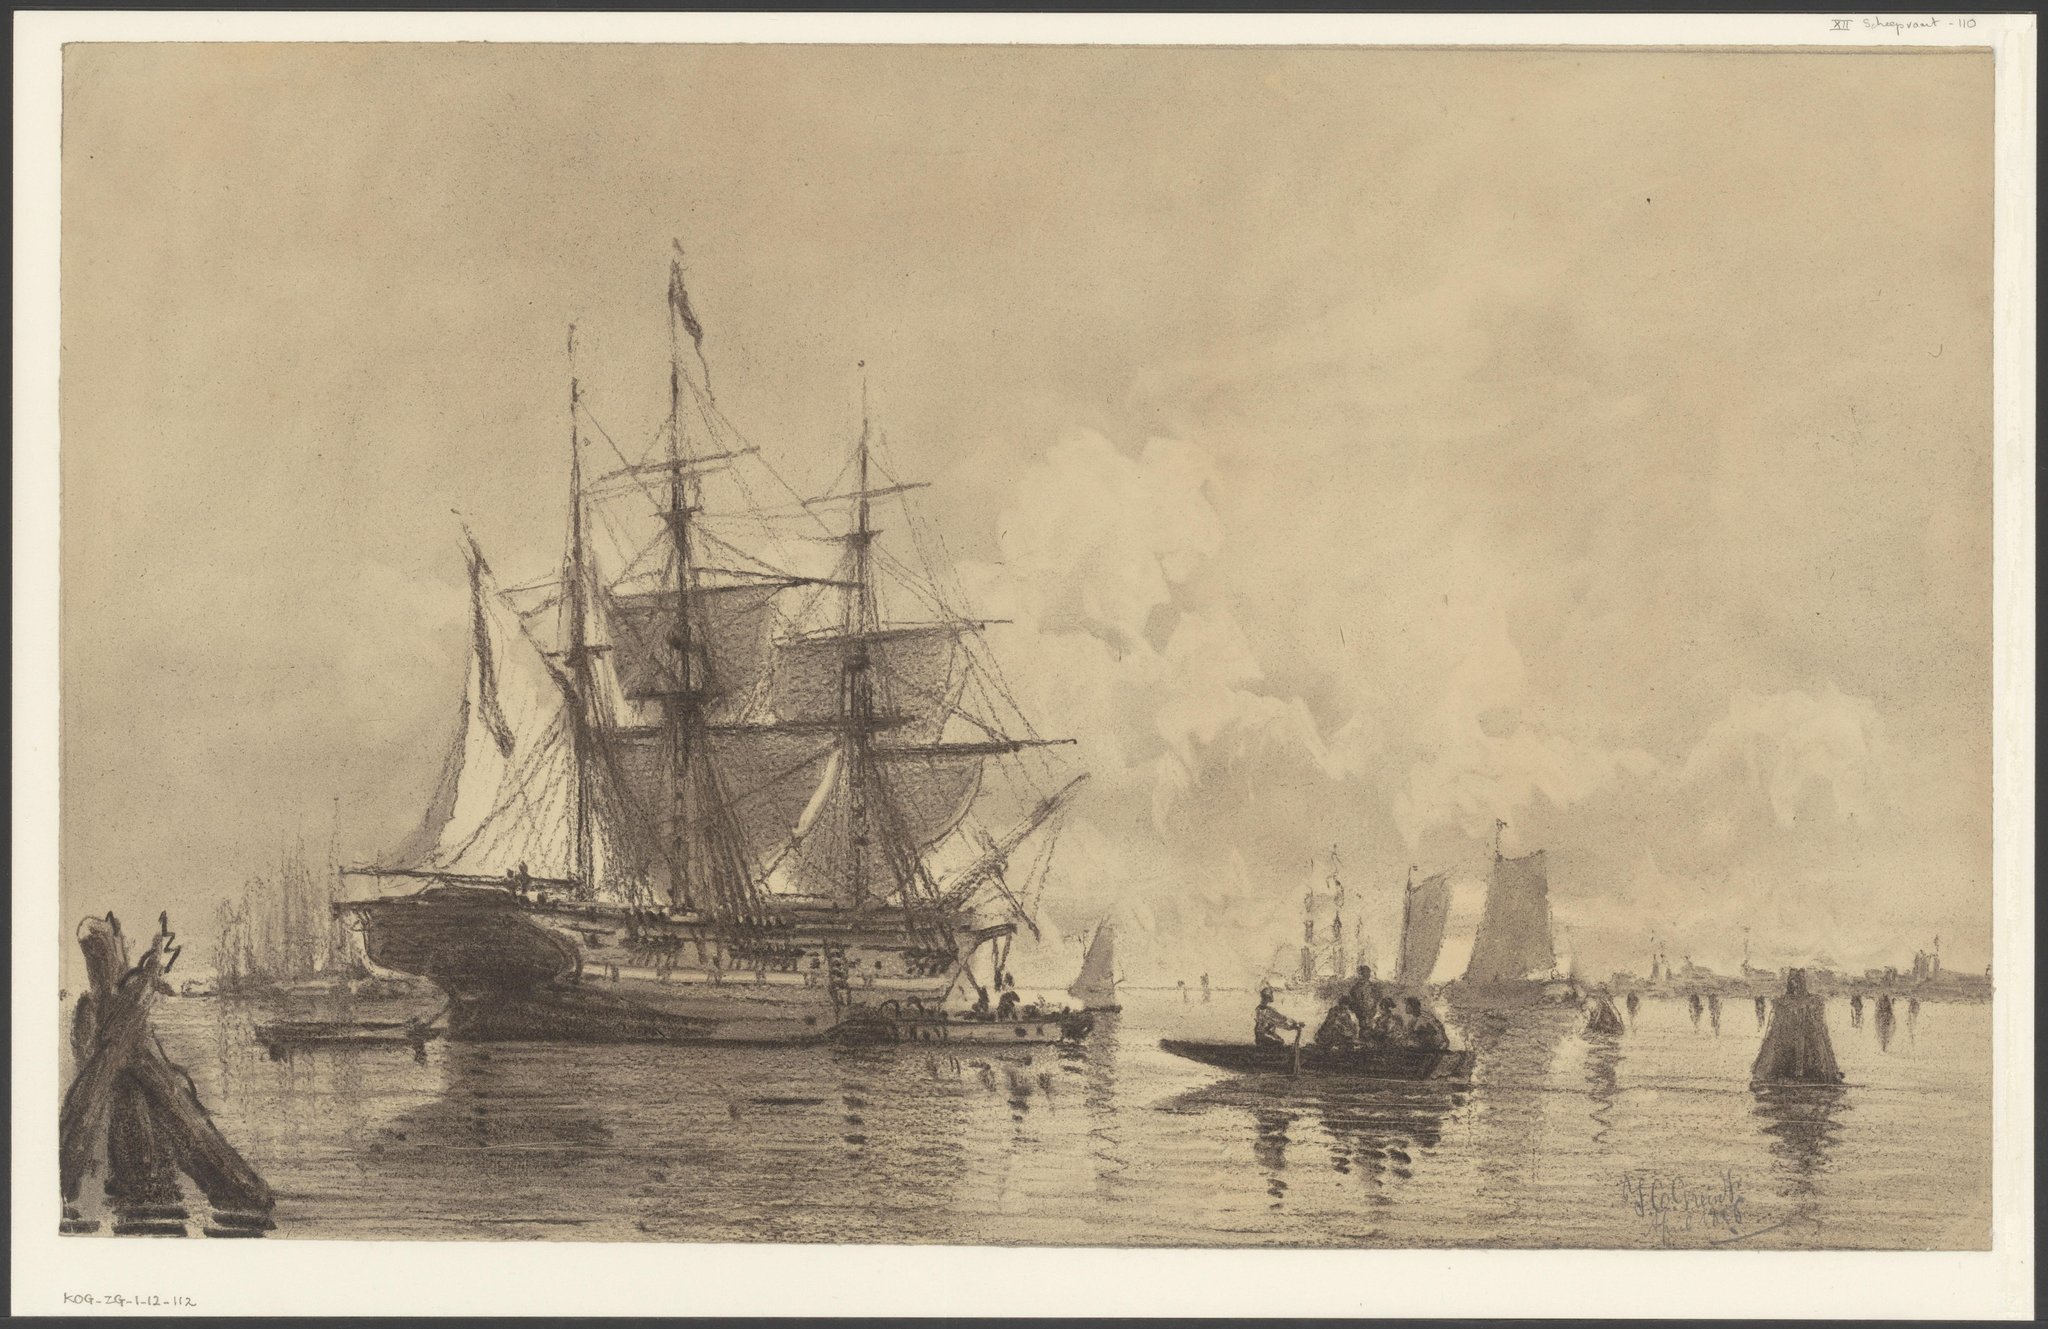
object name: drawing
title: Koopvaardijschip in de haven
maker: johan conrad greive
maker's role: draughtsman, painter, print maker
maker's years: 1837-1891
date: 1804-1856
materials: chalk, paper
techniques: brush, scoring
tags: harbour, sailing-ship, sailing-boat, rowing-boat, canoe, etc.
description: Onderwerpsrubrieken binnen de Atlas Zeden en Gewoonten: Handel, Nijverheid en Verkeer, Scheepsvaart.